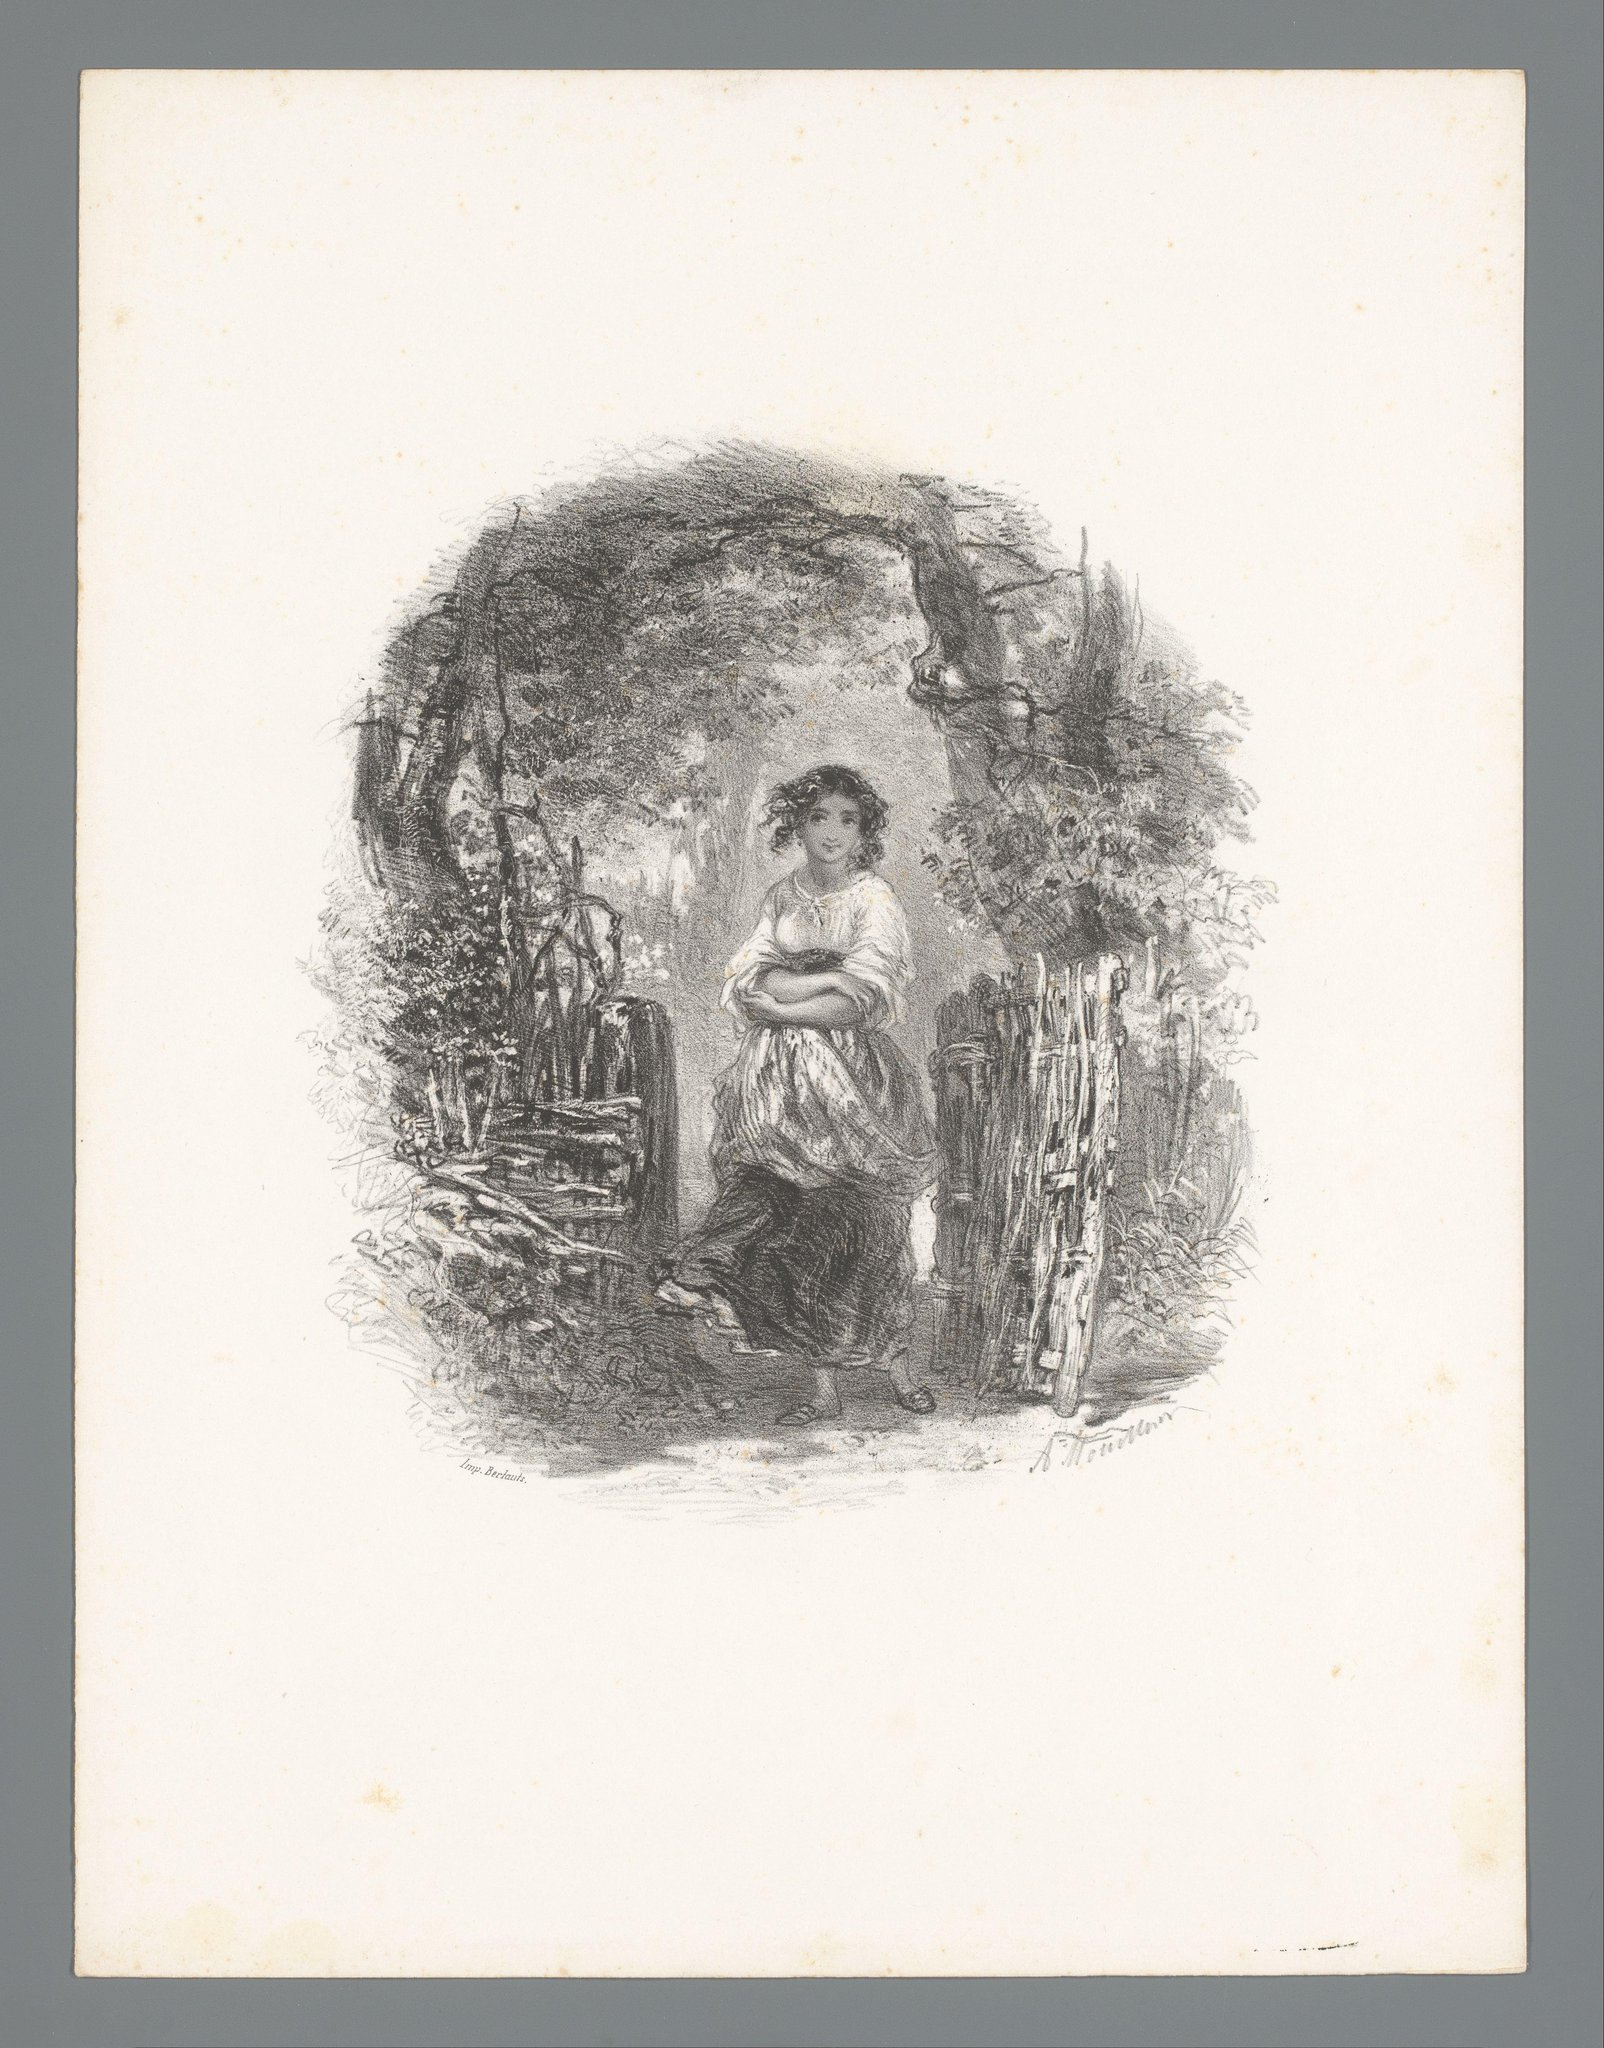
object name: print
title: Jonge vrouw met schort loopt door houten klaphek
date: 1830-1880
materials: paper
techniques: lithograph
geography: paris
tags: adolescent, young woman, maiden, kissing gate, clap gate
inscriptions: collector's mark: Lugt 964